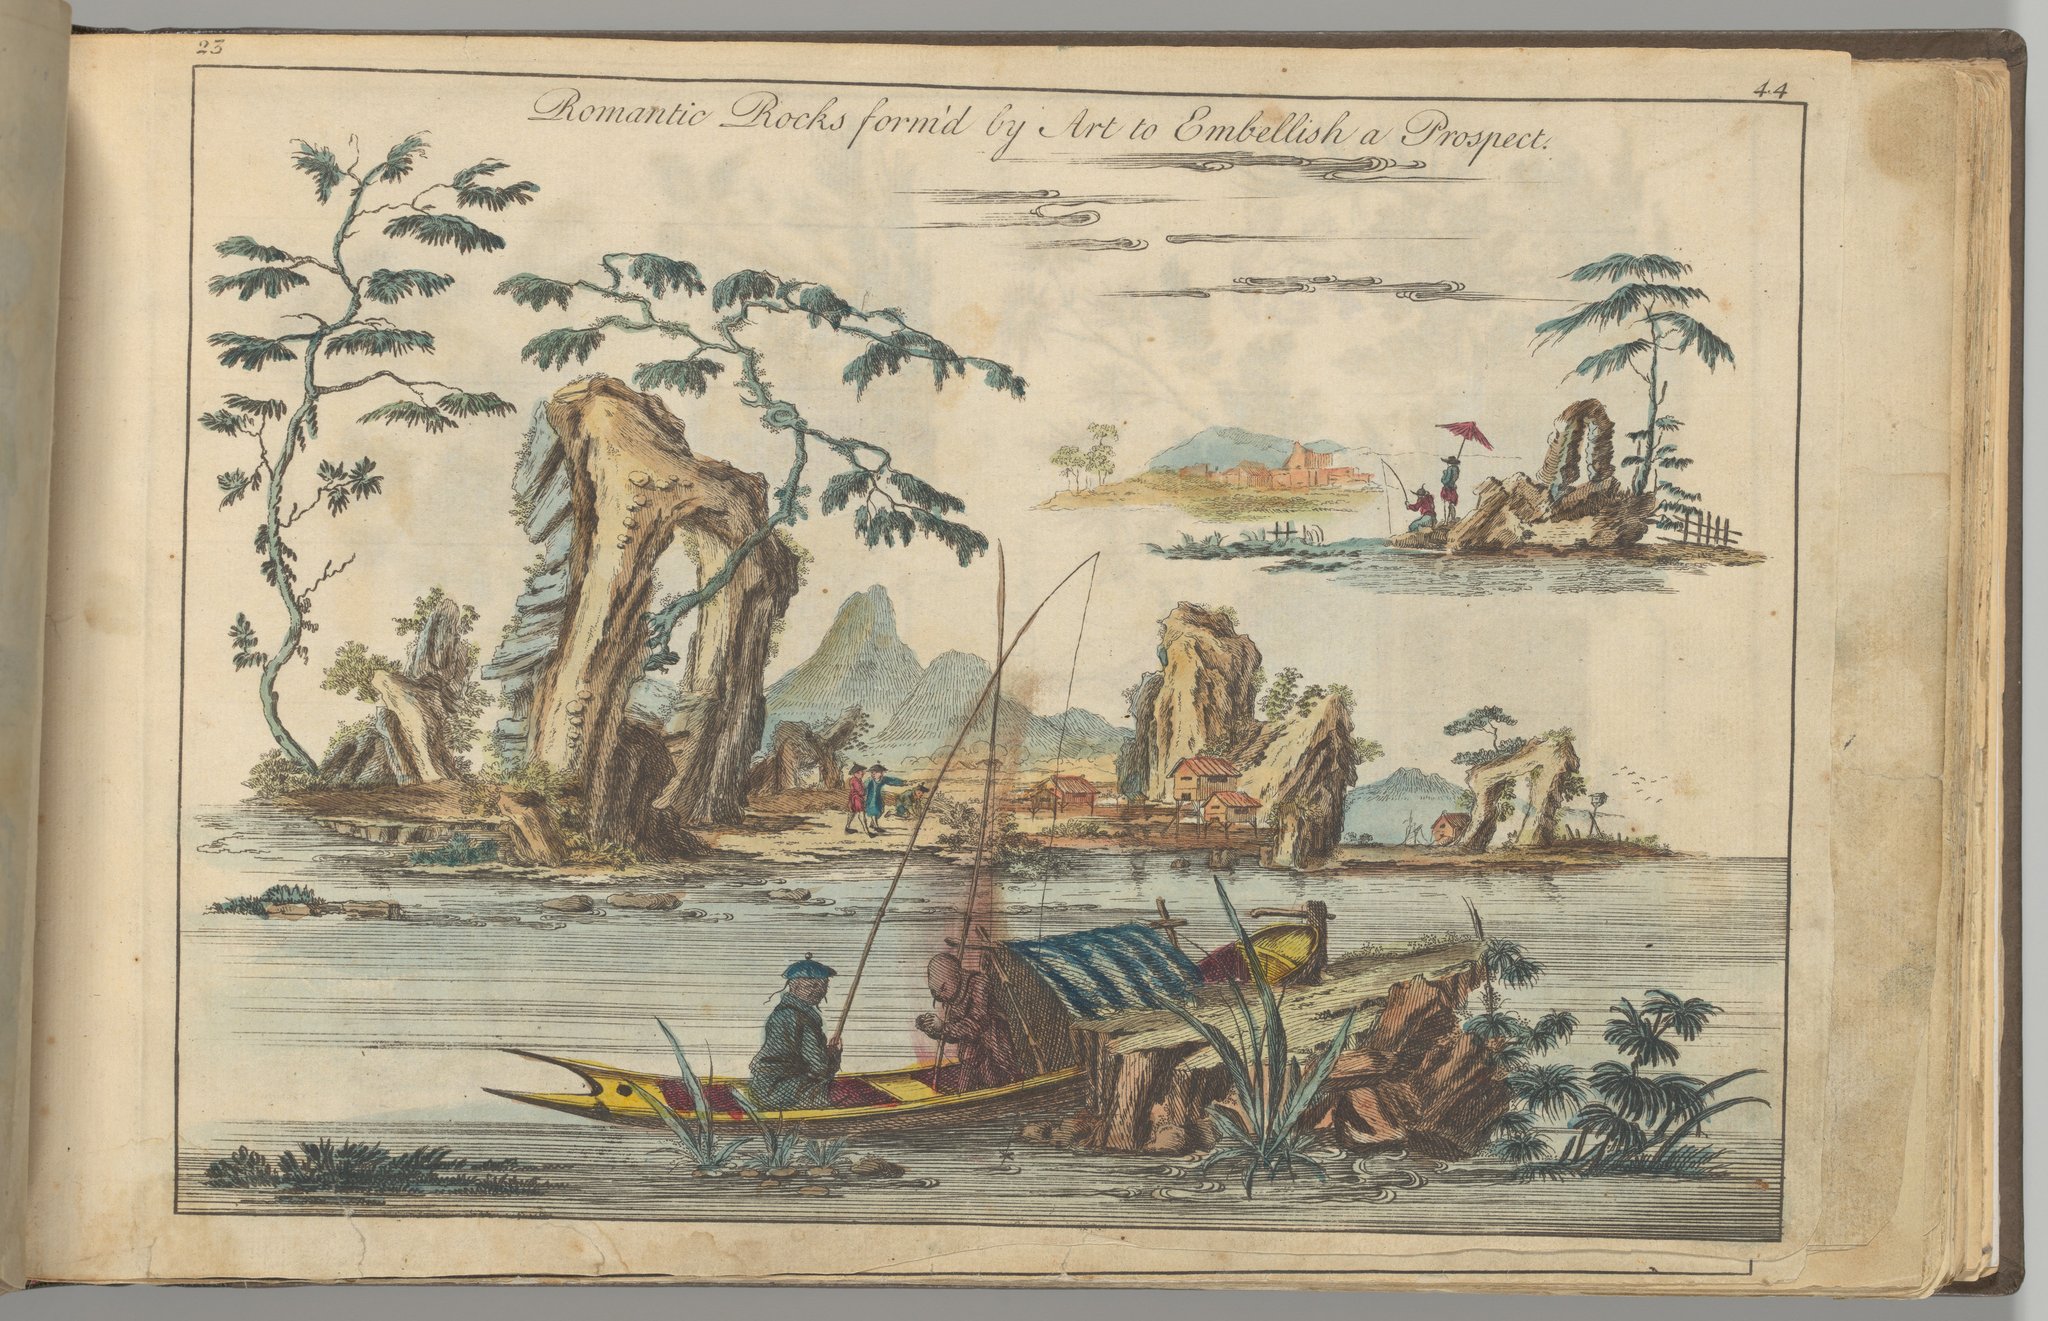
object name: book print ornament architecture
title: Ladies Amusement: Or, The Whole Art of Japanning Made Easy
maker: jean pillement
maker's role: artist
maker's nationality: french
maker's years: 1728-1808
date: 1760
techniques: engraving, etching, hand coloring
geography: england